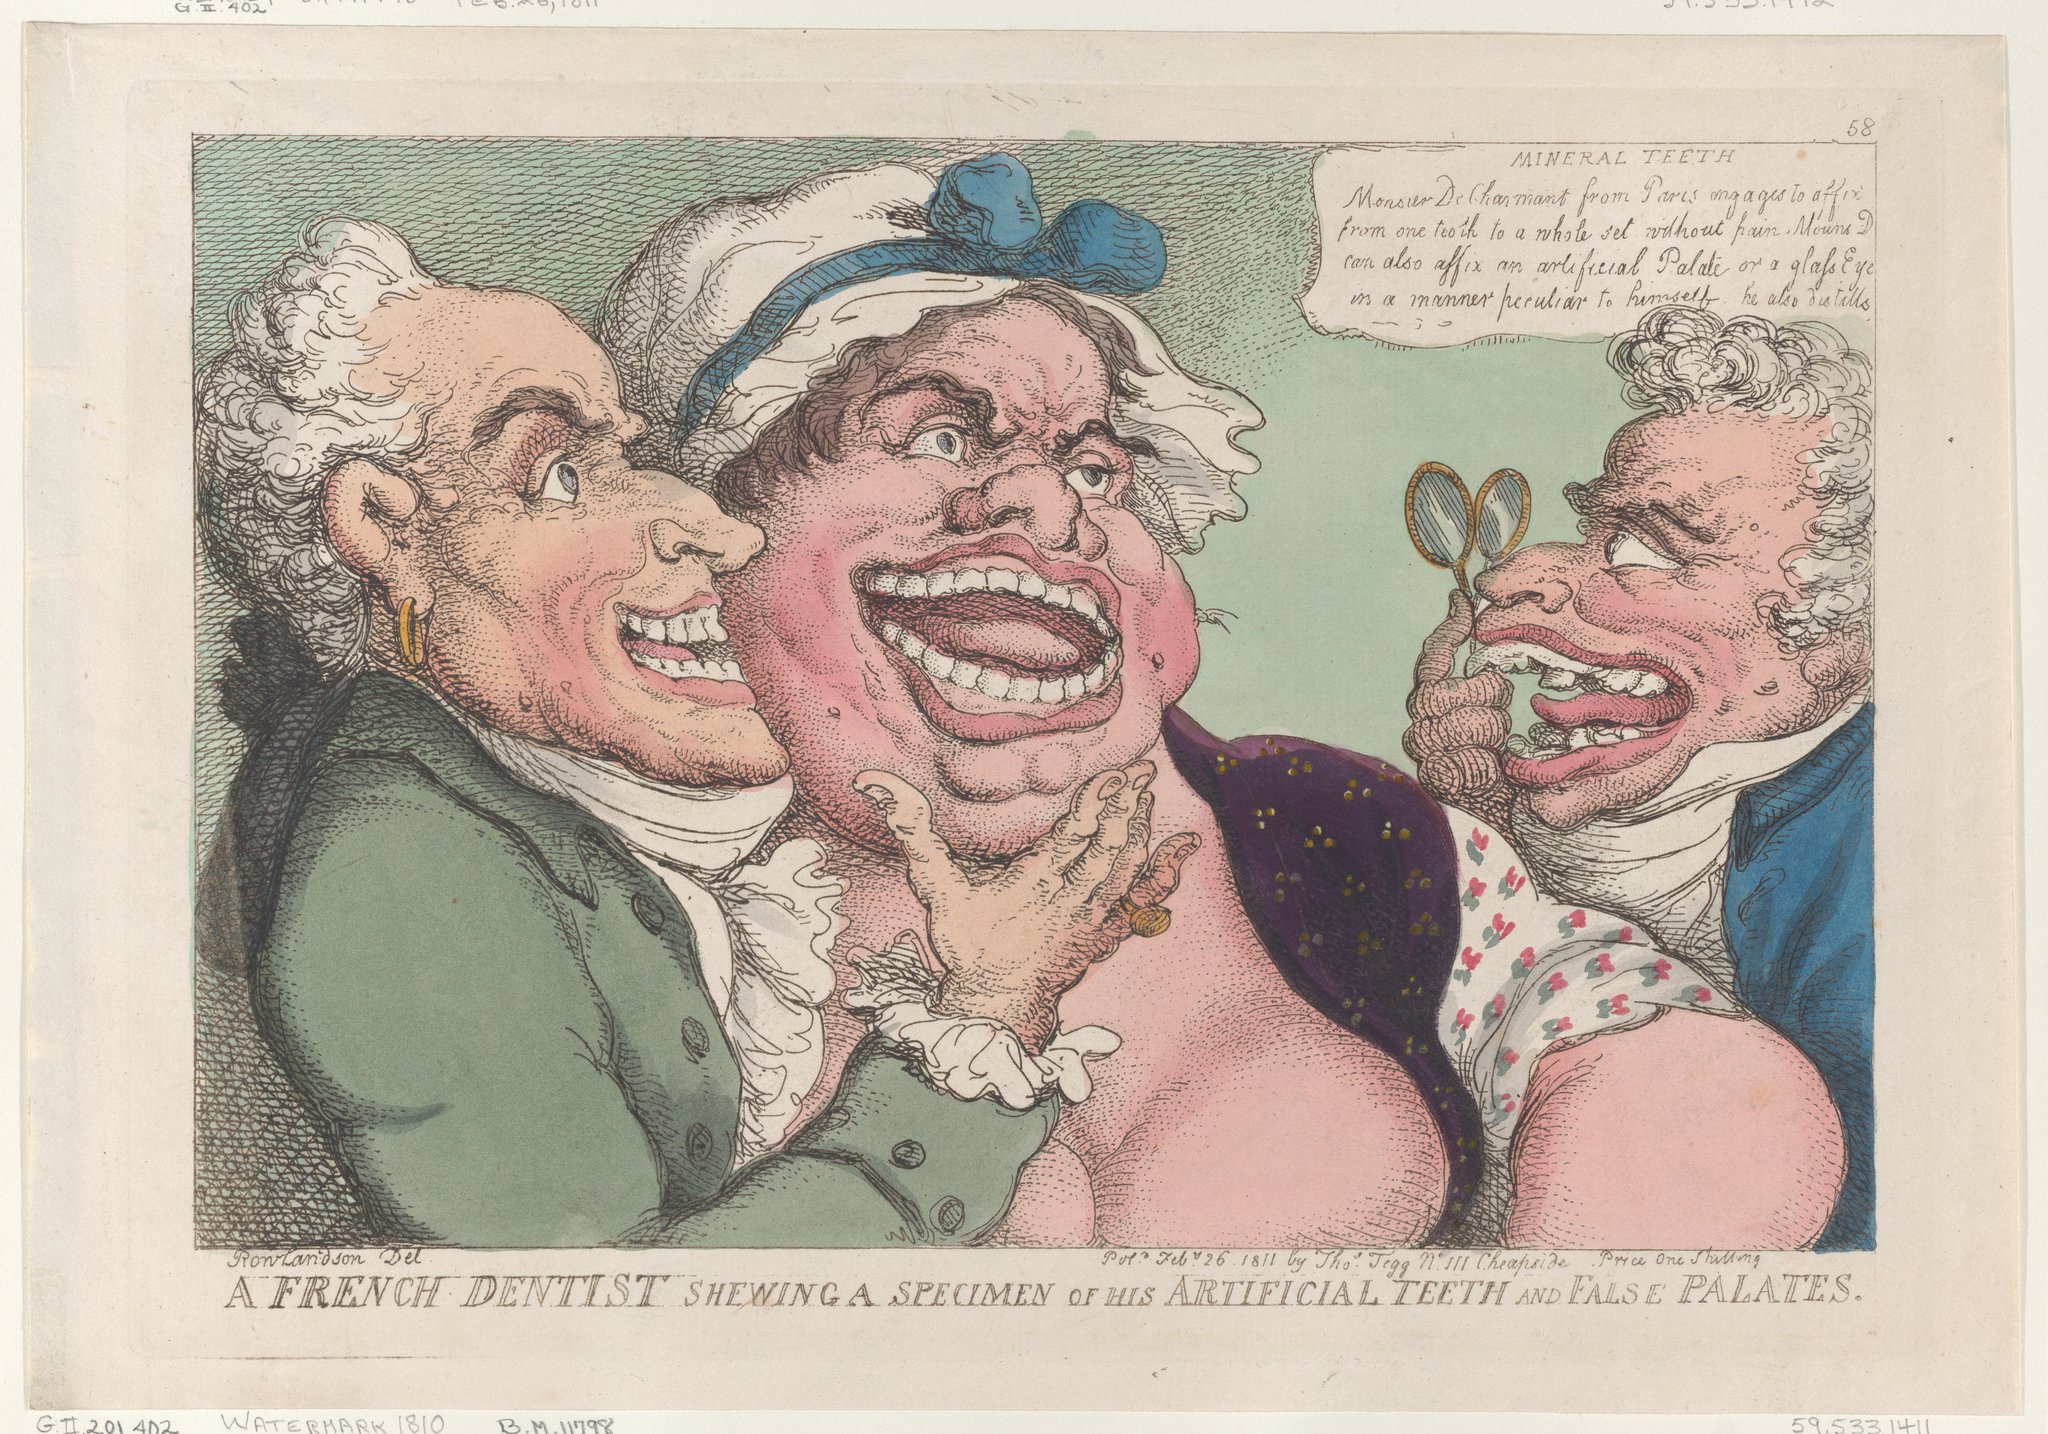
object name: print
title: A French Dentist Shewing a Specimen of His Artificial Teeth and False Palates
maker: thomas rowlandson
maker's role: artist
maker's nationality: british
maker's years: 1757-1827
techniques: etching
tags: satire,men,women